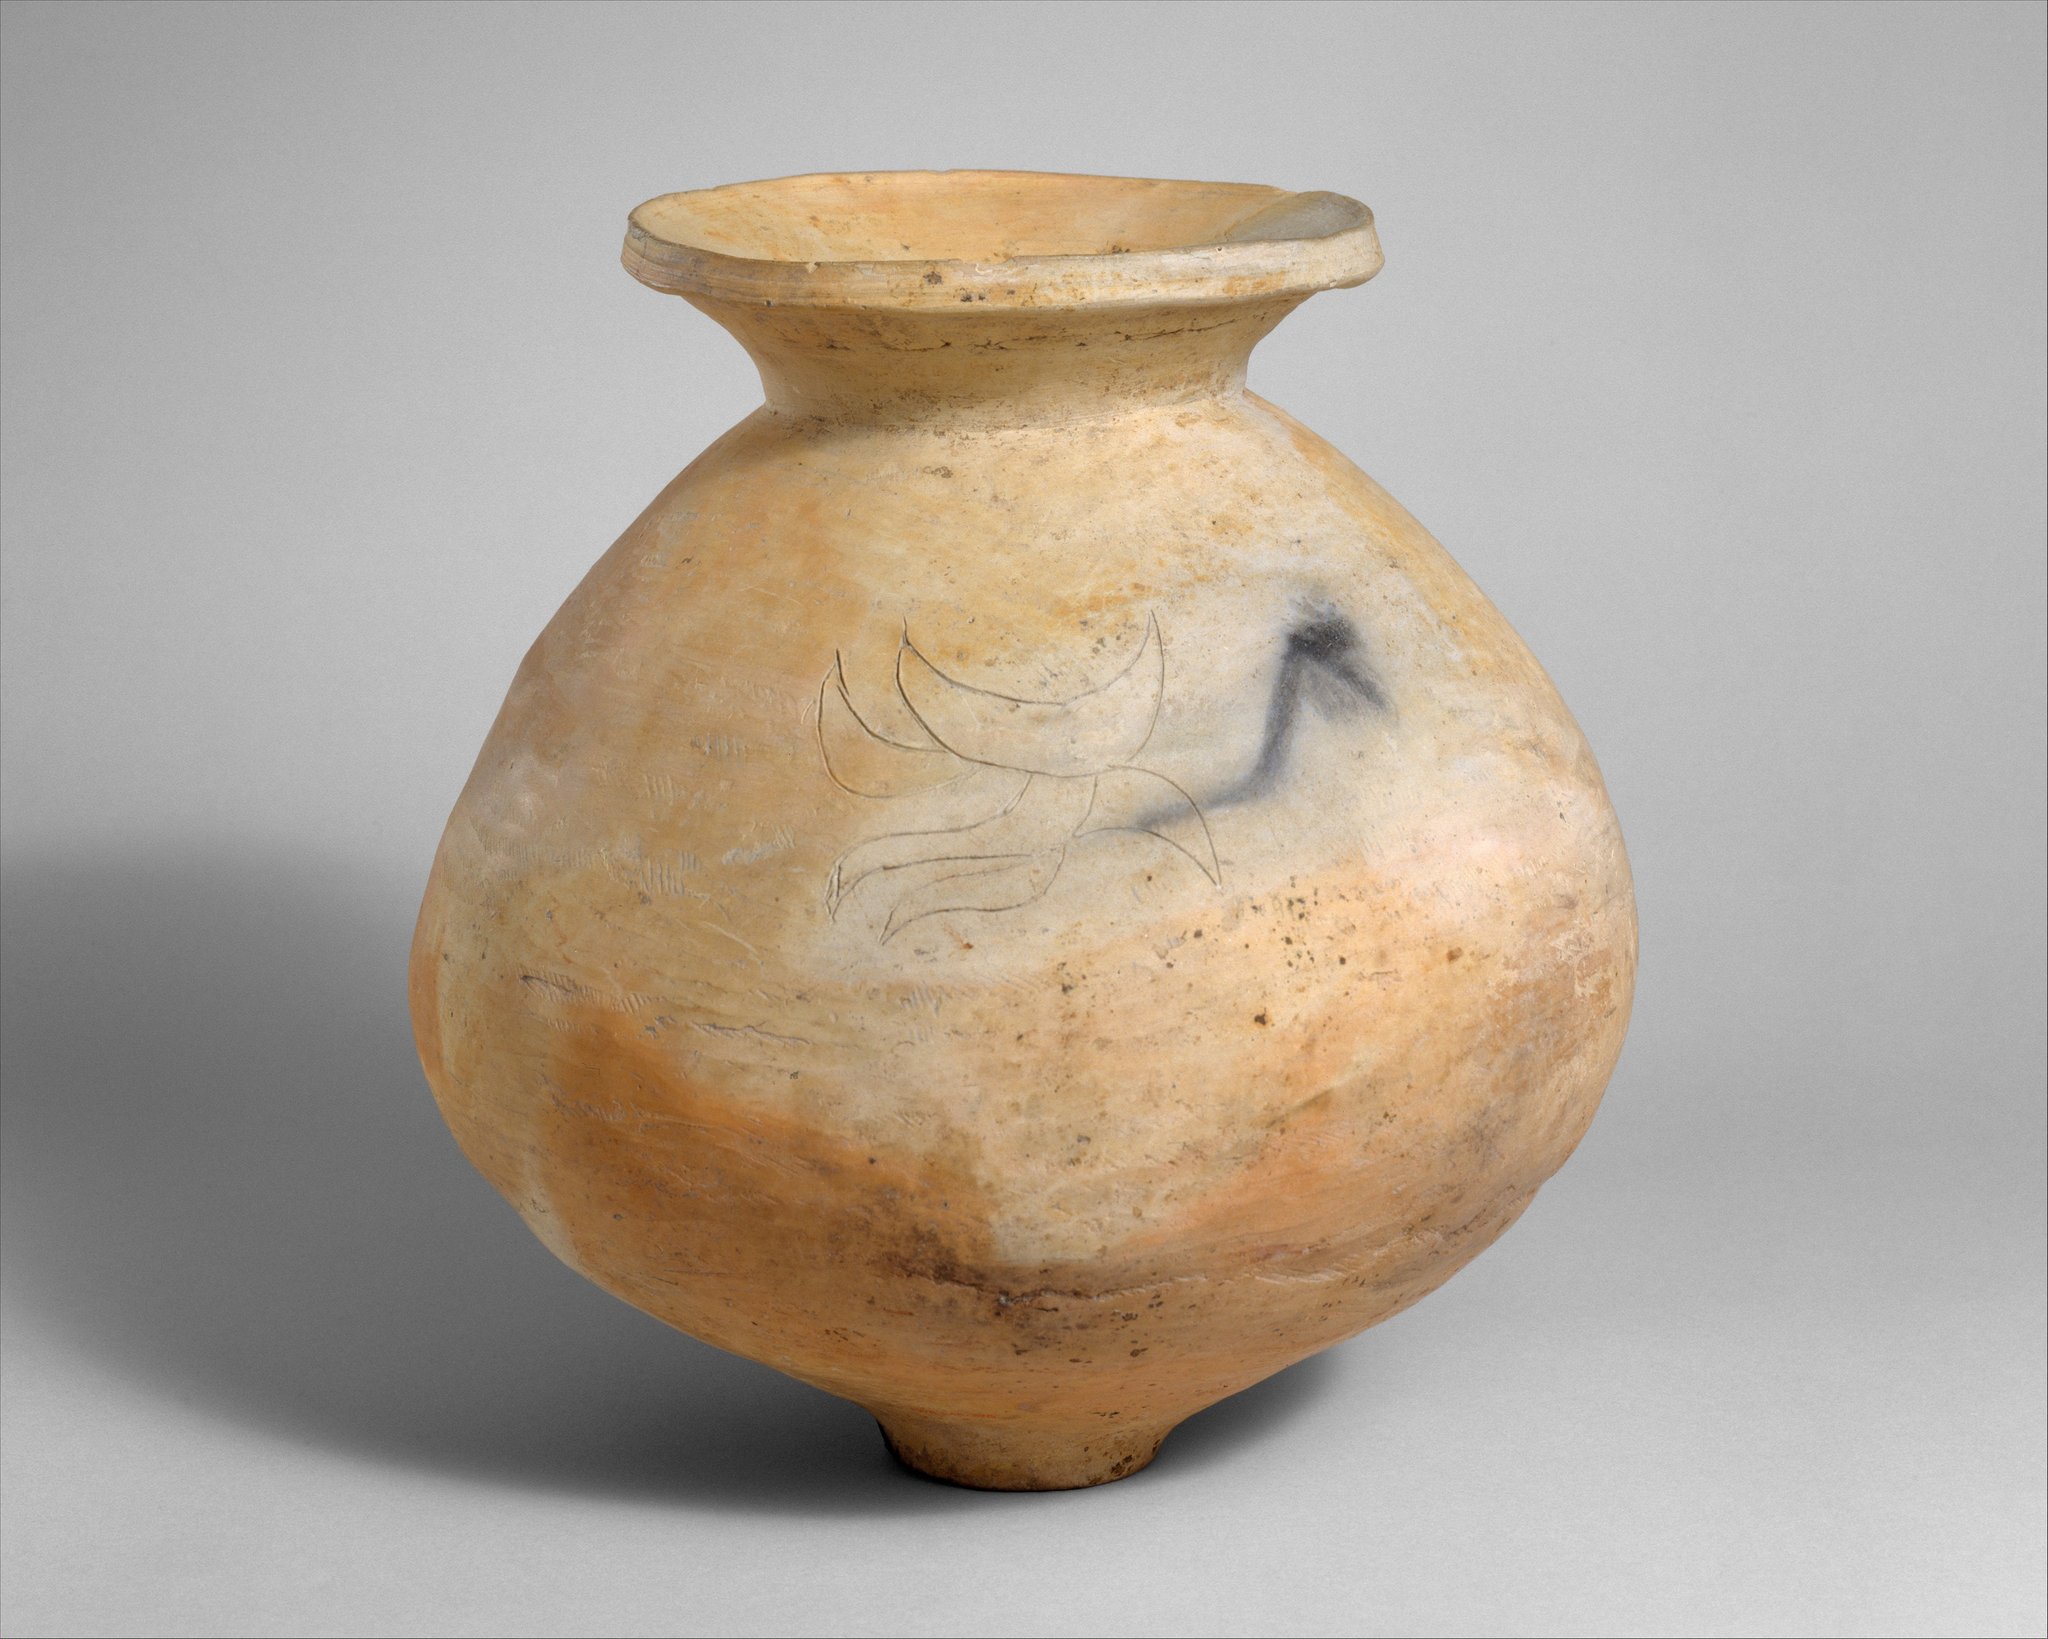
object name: jar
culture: japanese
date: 101-400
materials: earthenware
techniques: incising